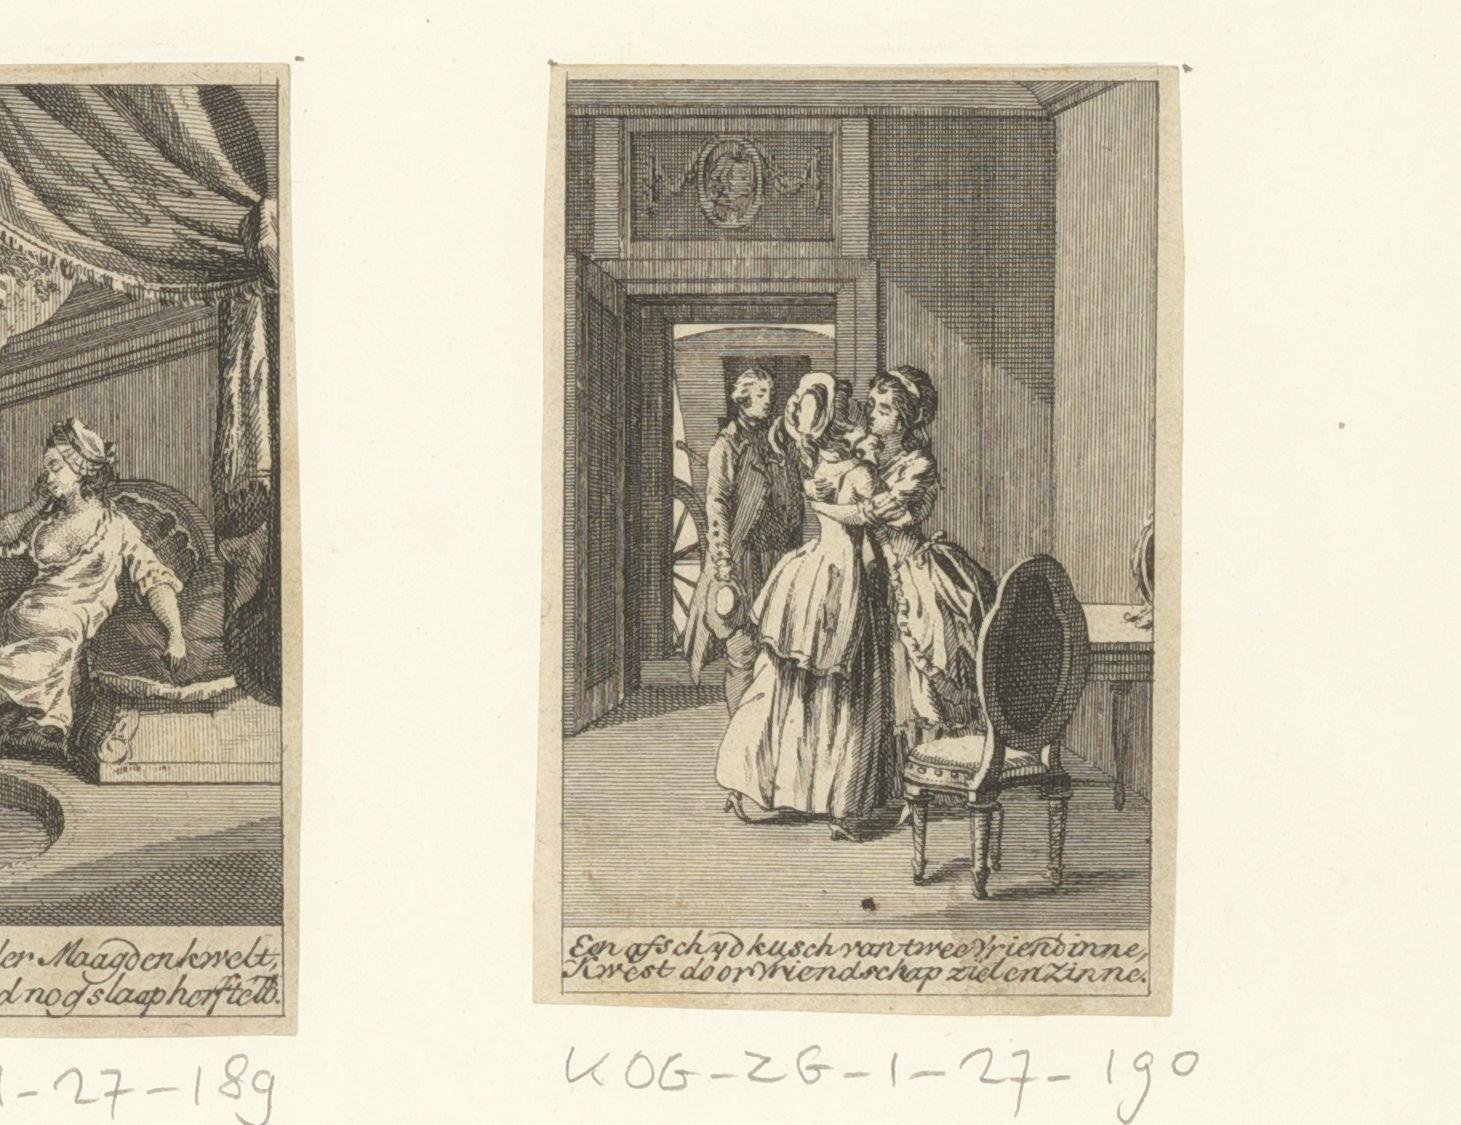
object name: print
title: Vriendinnen kussen elkaar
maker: Anonymous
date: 1725-1799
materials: paper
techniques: engraving, etching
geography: netherlands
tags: embracing each other, kissing, departure ~ travelling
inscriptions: collector's mark: Lugt 1641, collector's mark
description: Gebruikt als illustratie in een onbekende almanak.